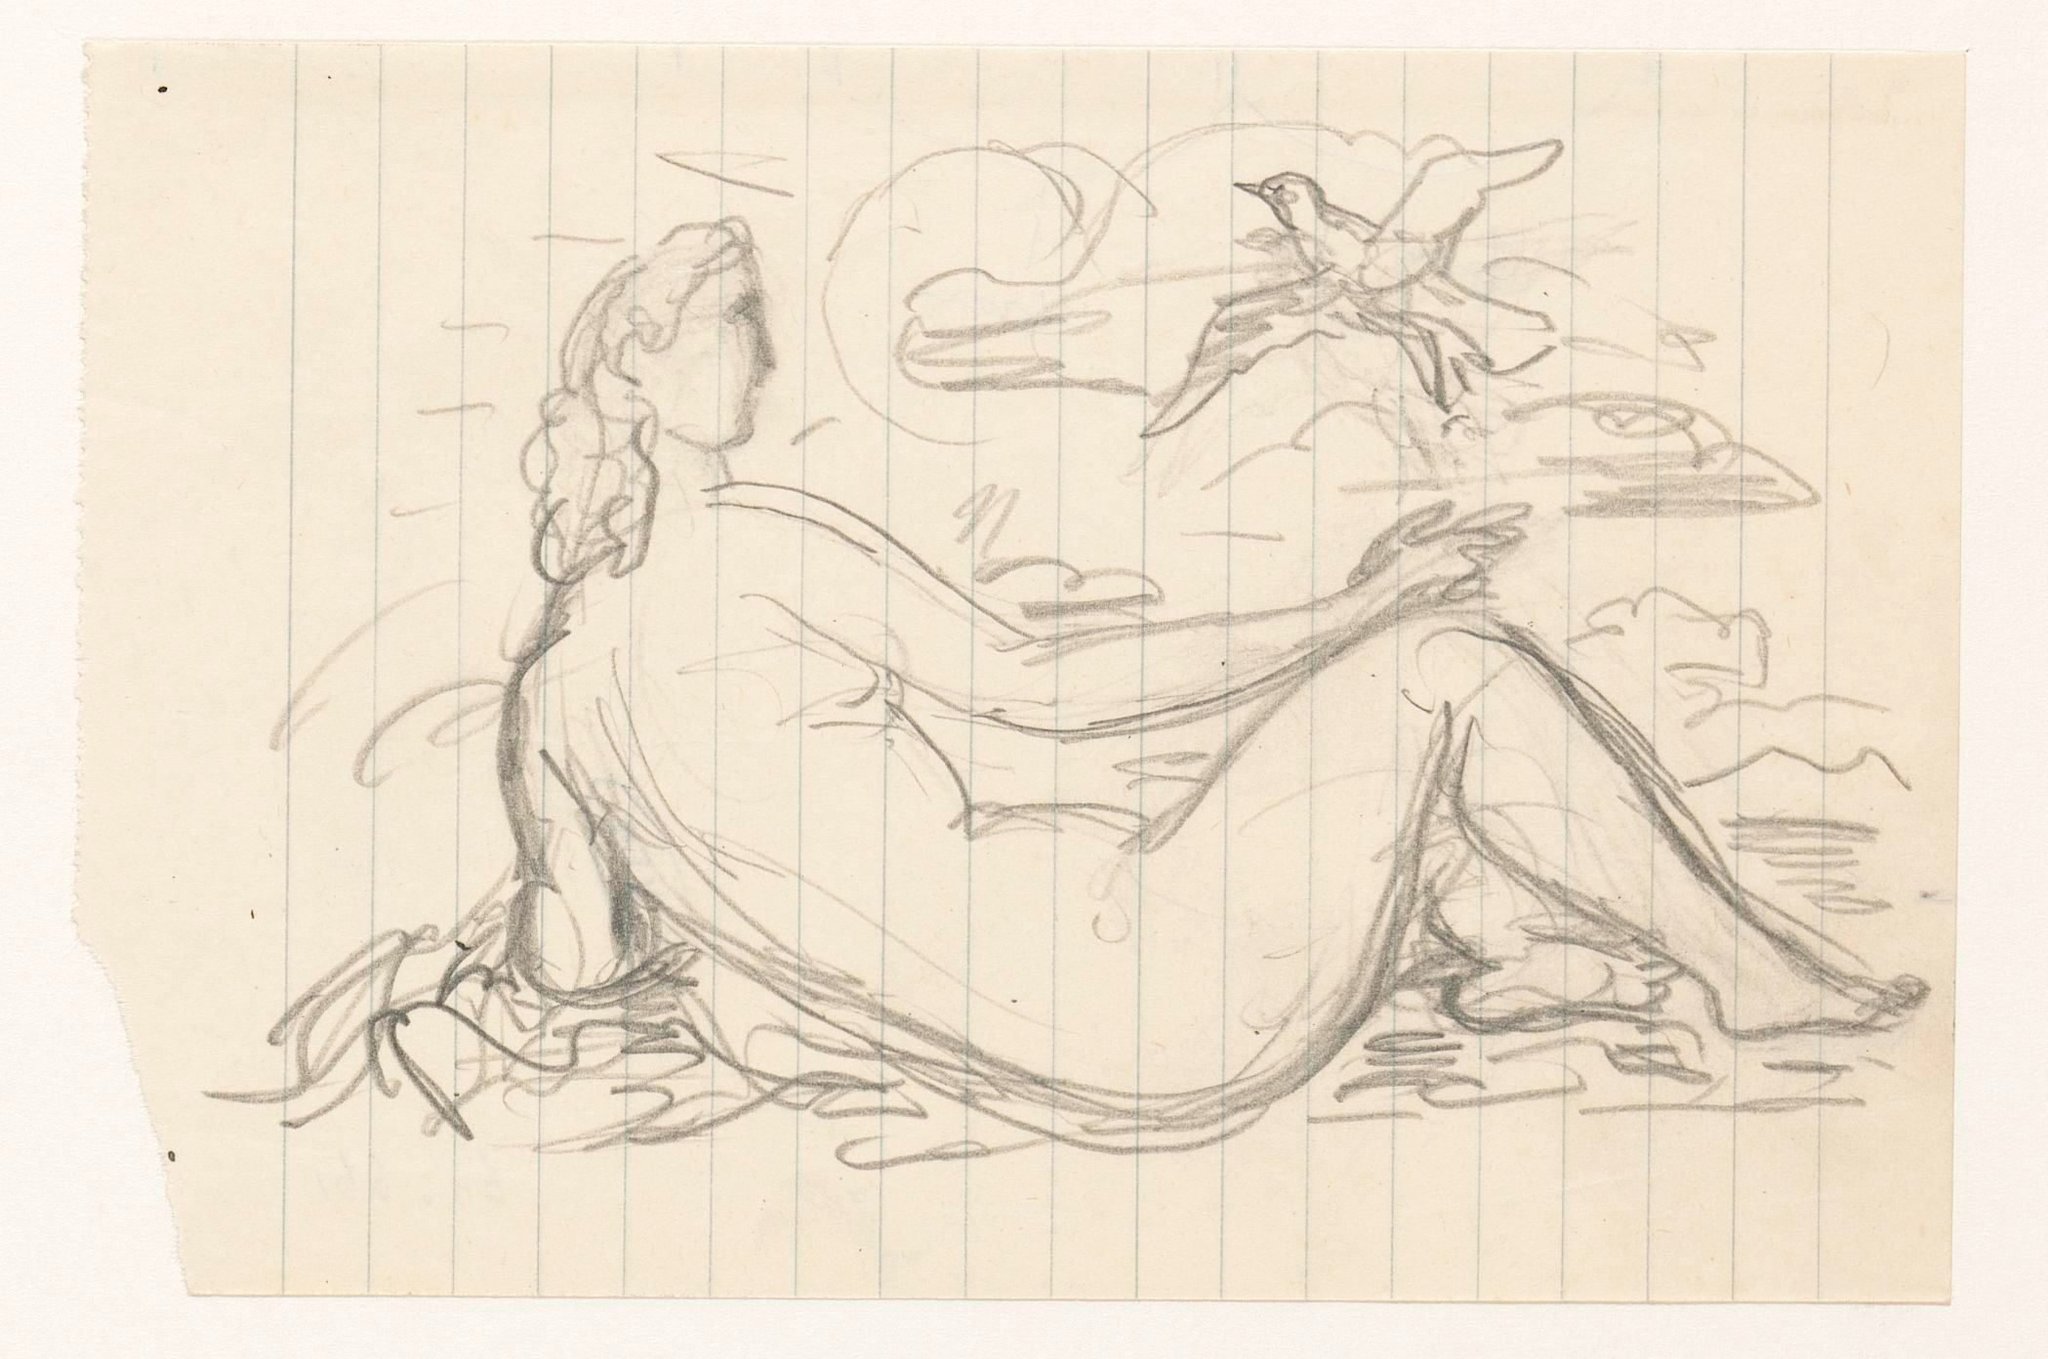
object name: drawing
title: Liggend vrouwelijk naakt aan zee met zeemeeuw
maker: leo gestel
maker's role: draughtsman, print maker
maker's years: 1881-1941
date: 1891-1941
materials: paper, pencil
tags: lying on one side, with uplifted upper part of the body and leaning on the arm - aa - female human figure (+ nude human being), shore-birds and wading-birds: gull, beach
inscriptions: collector's mark: Lugt 2228